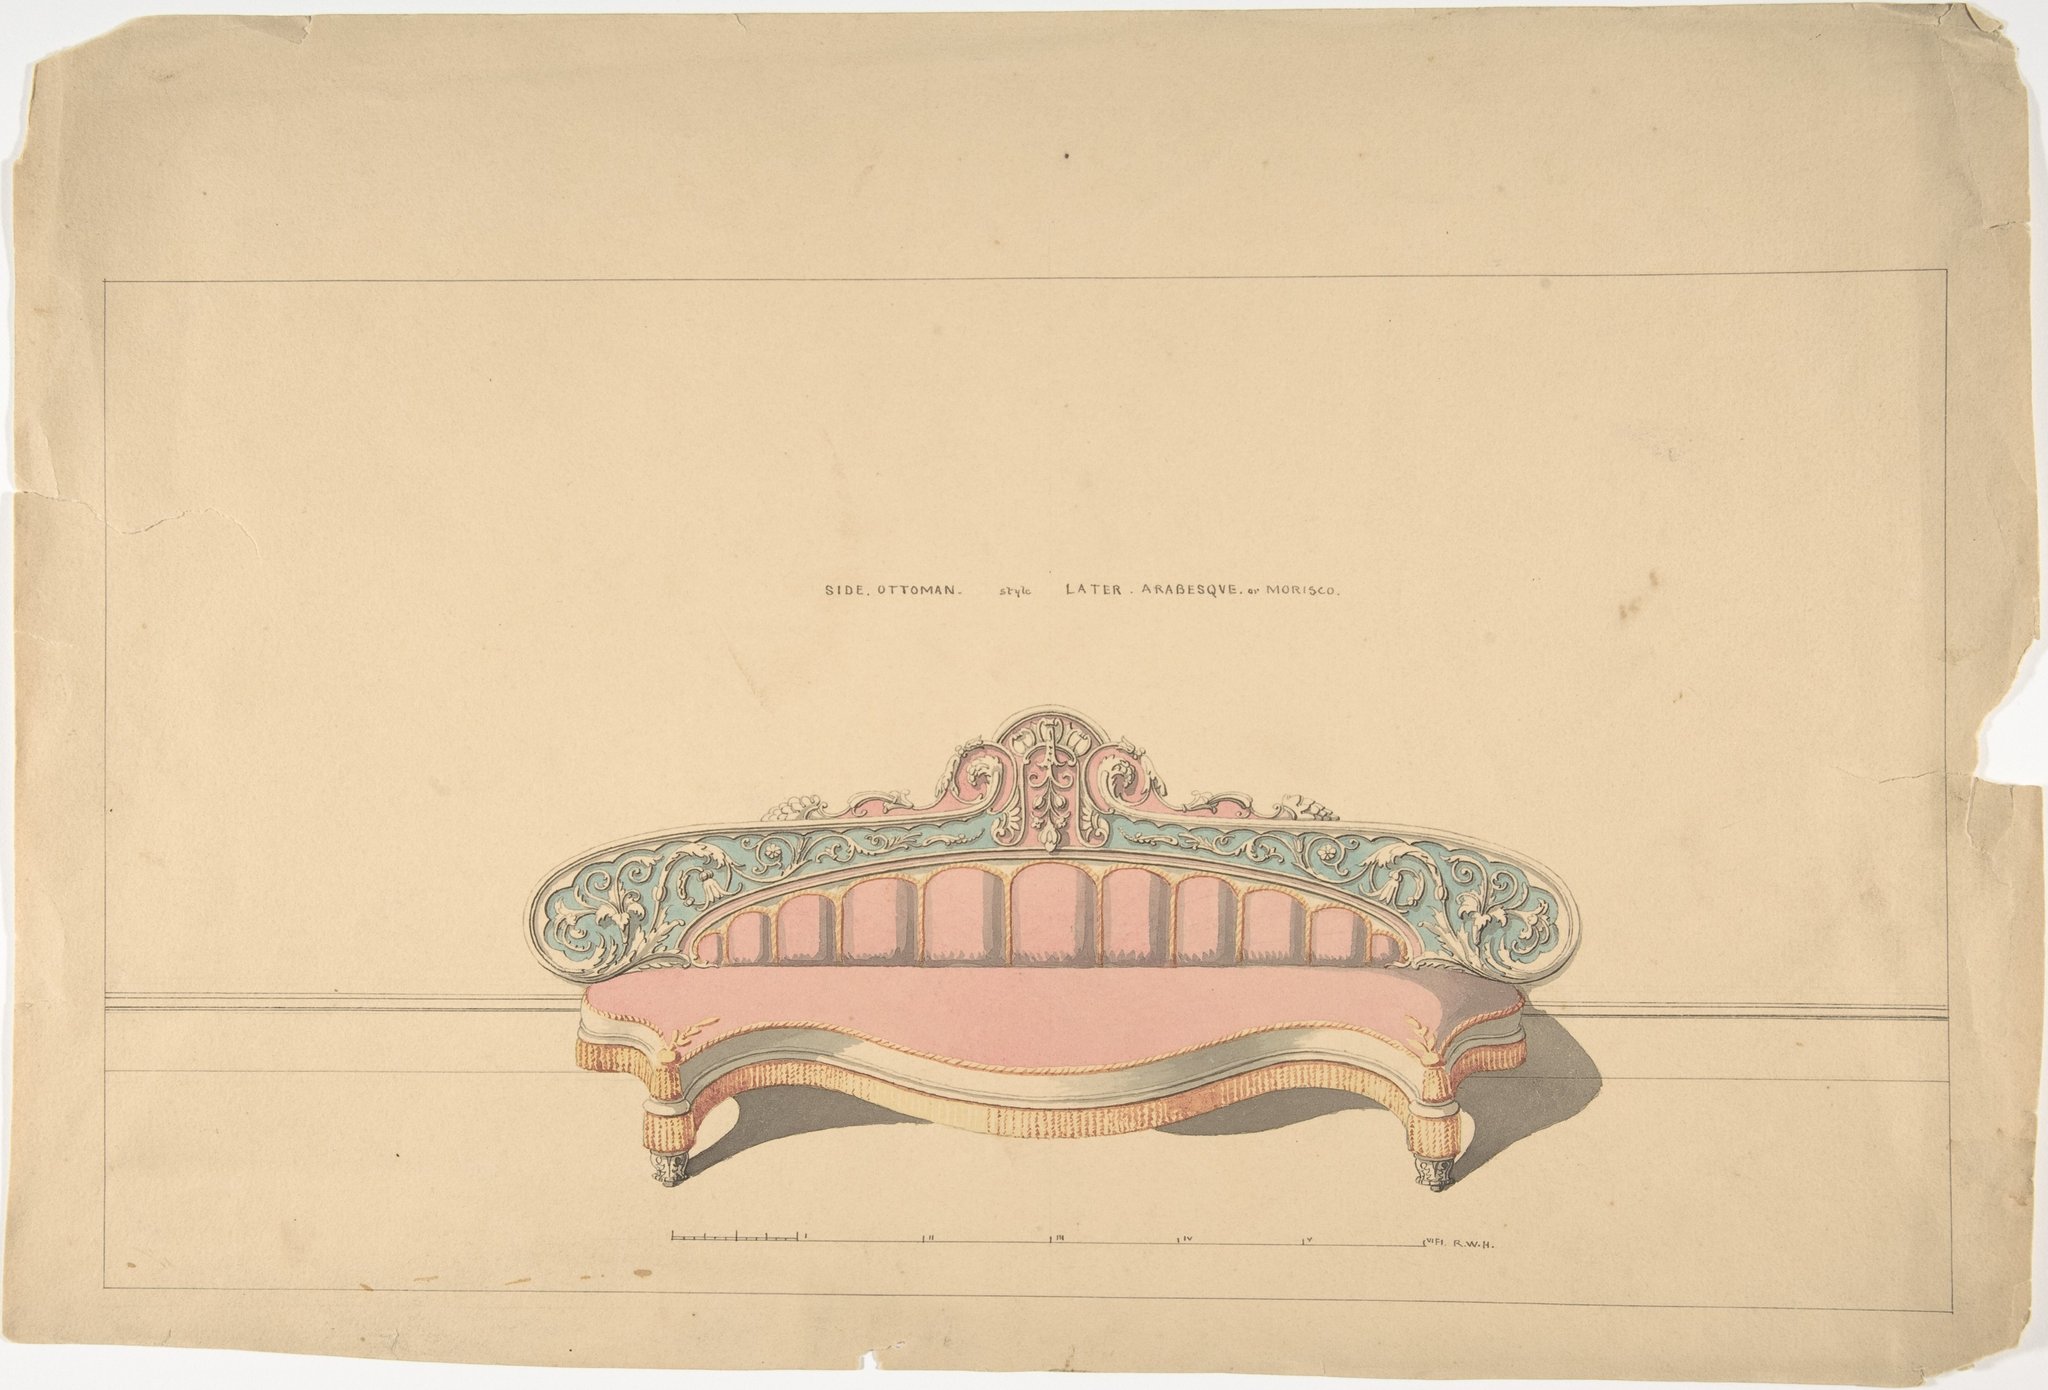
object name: drawing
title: Design for Side Ottoman, Later Arabesque or Morisco Style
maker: robert william hume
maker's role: artist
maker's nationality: british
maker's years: 1816-1904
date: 1835-1900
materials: graphite, ink, watercolor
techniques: pen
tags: furniture